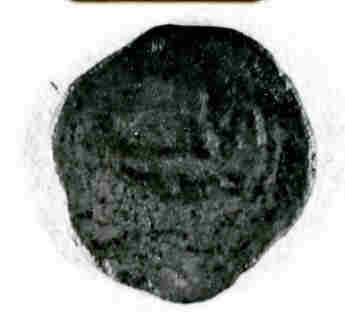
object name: coin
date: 601-1400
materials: copper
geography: iran